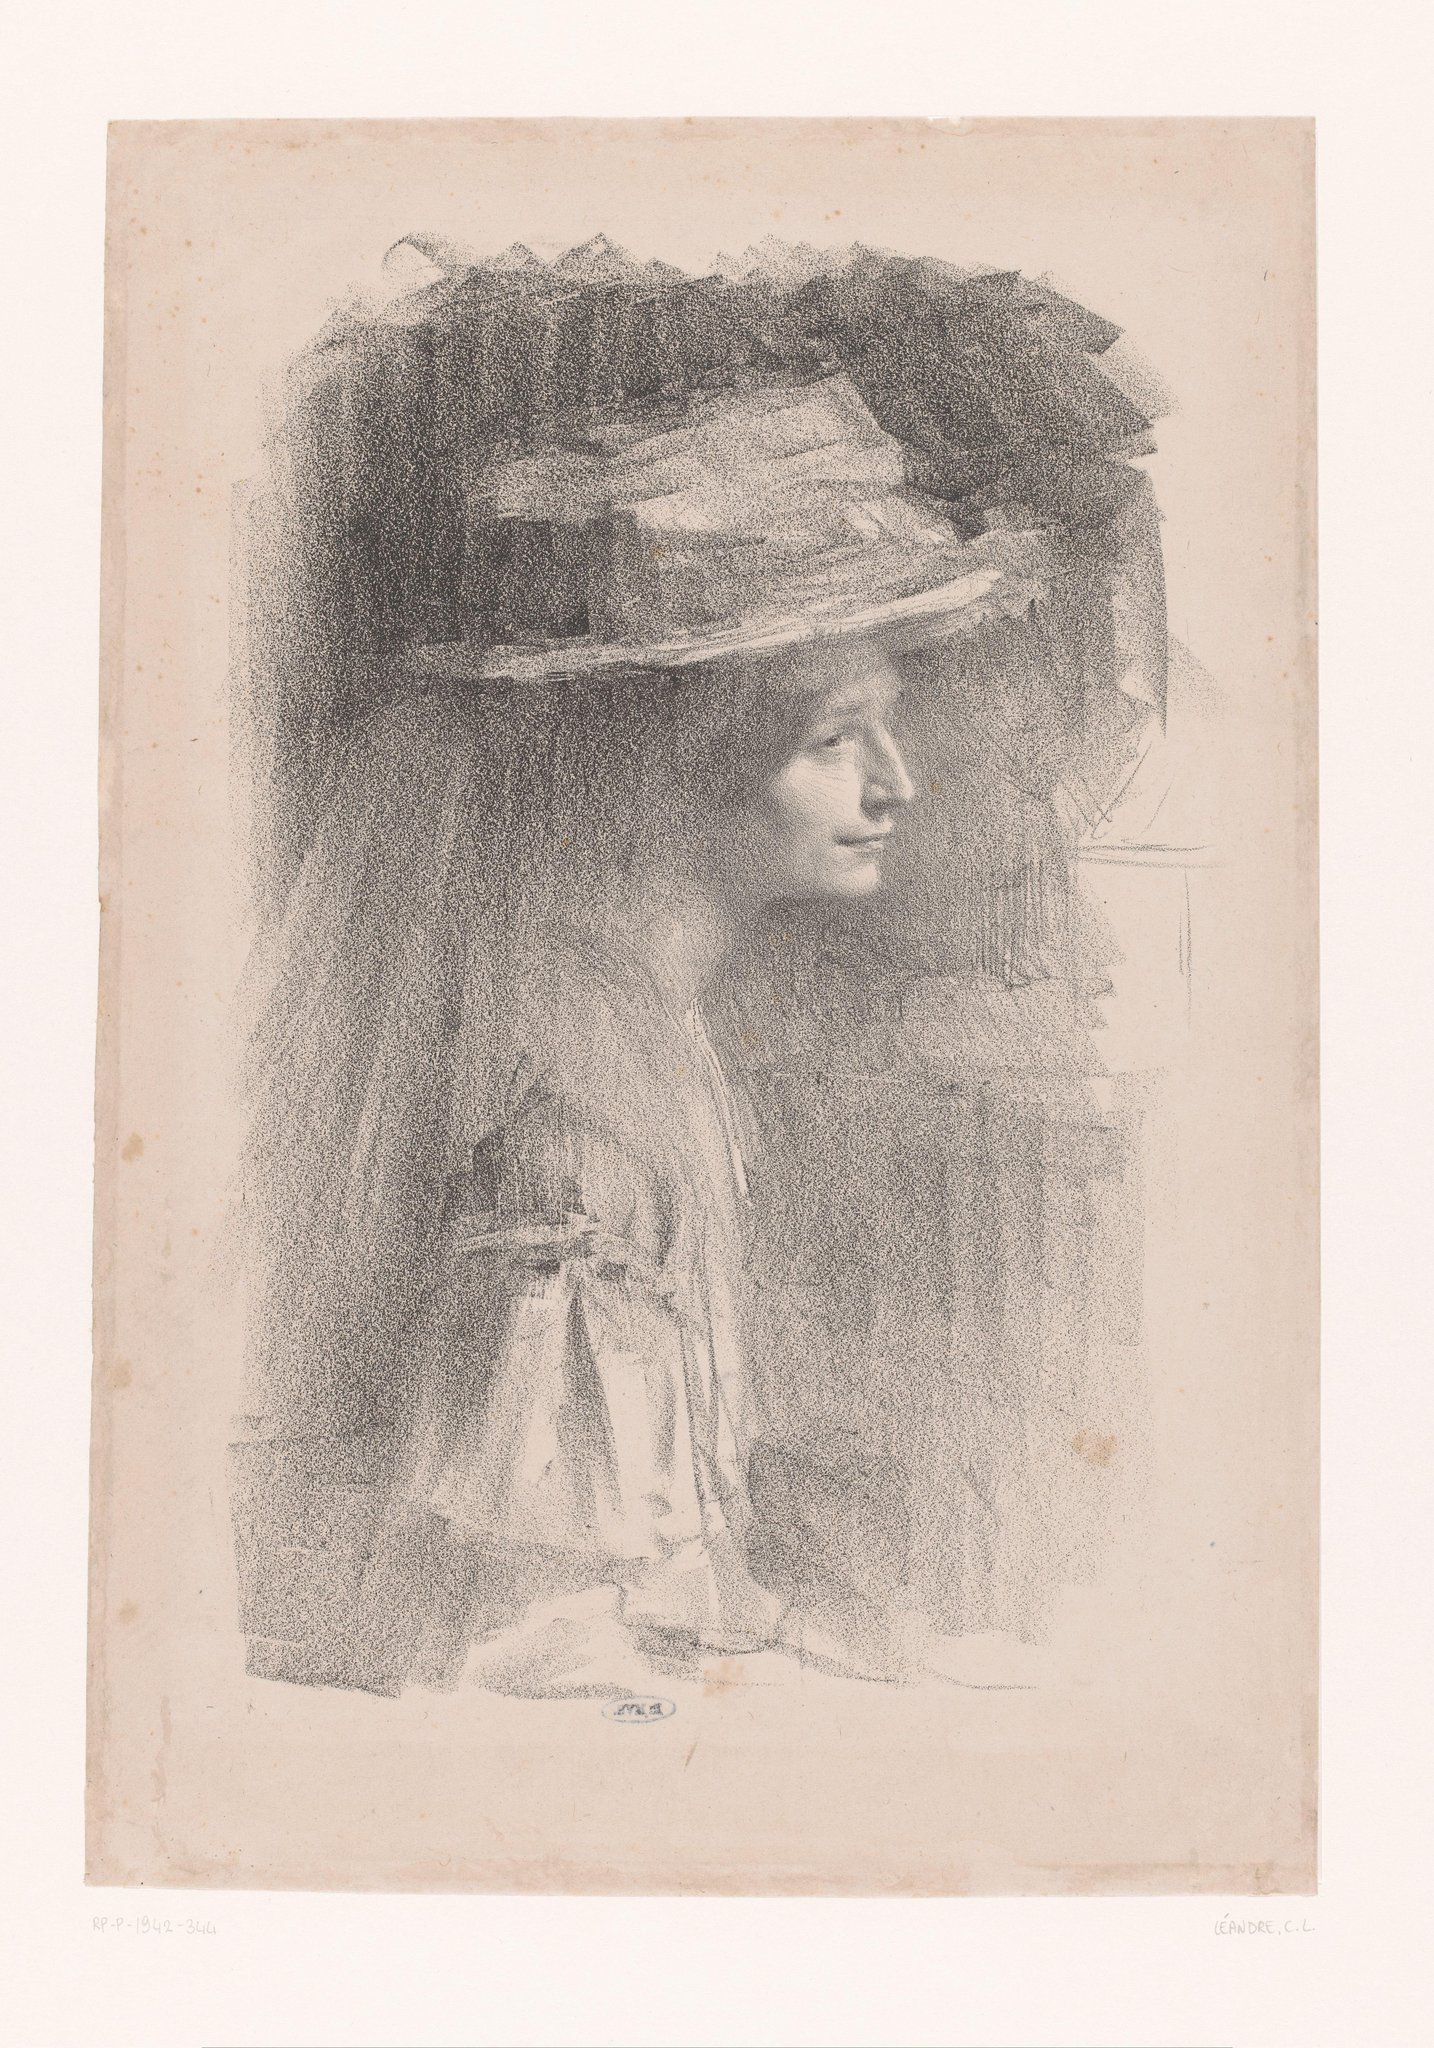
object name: print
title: Portret van een jonge vrouw met hoed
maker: charles lucien léandre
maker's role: draughtsman, print maker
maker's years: 1862-1934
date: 1891-1934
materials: paper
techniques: lithography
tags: head-gear: hat, anonymous historical person portrayed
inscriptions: collector's mark: Lugt 2228a